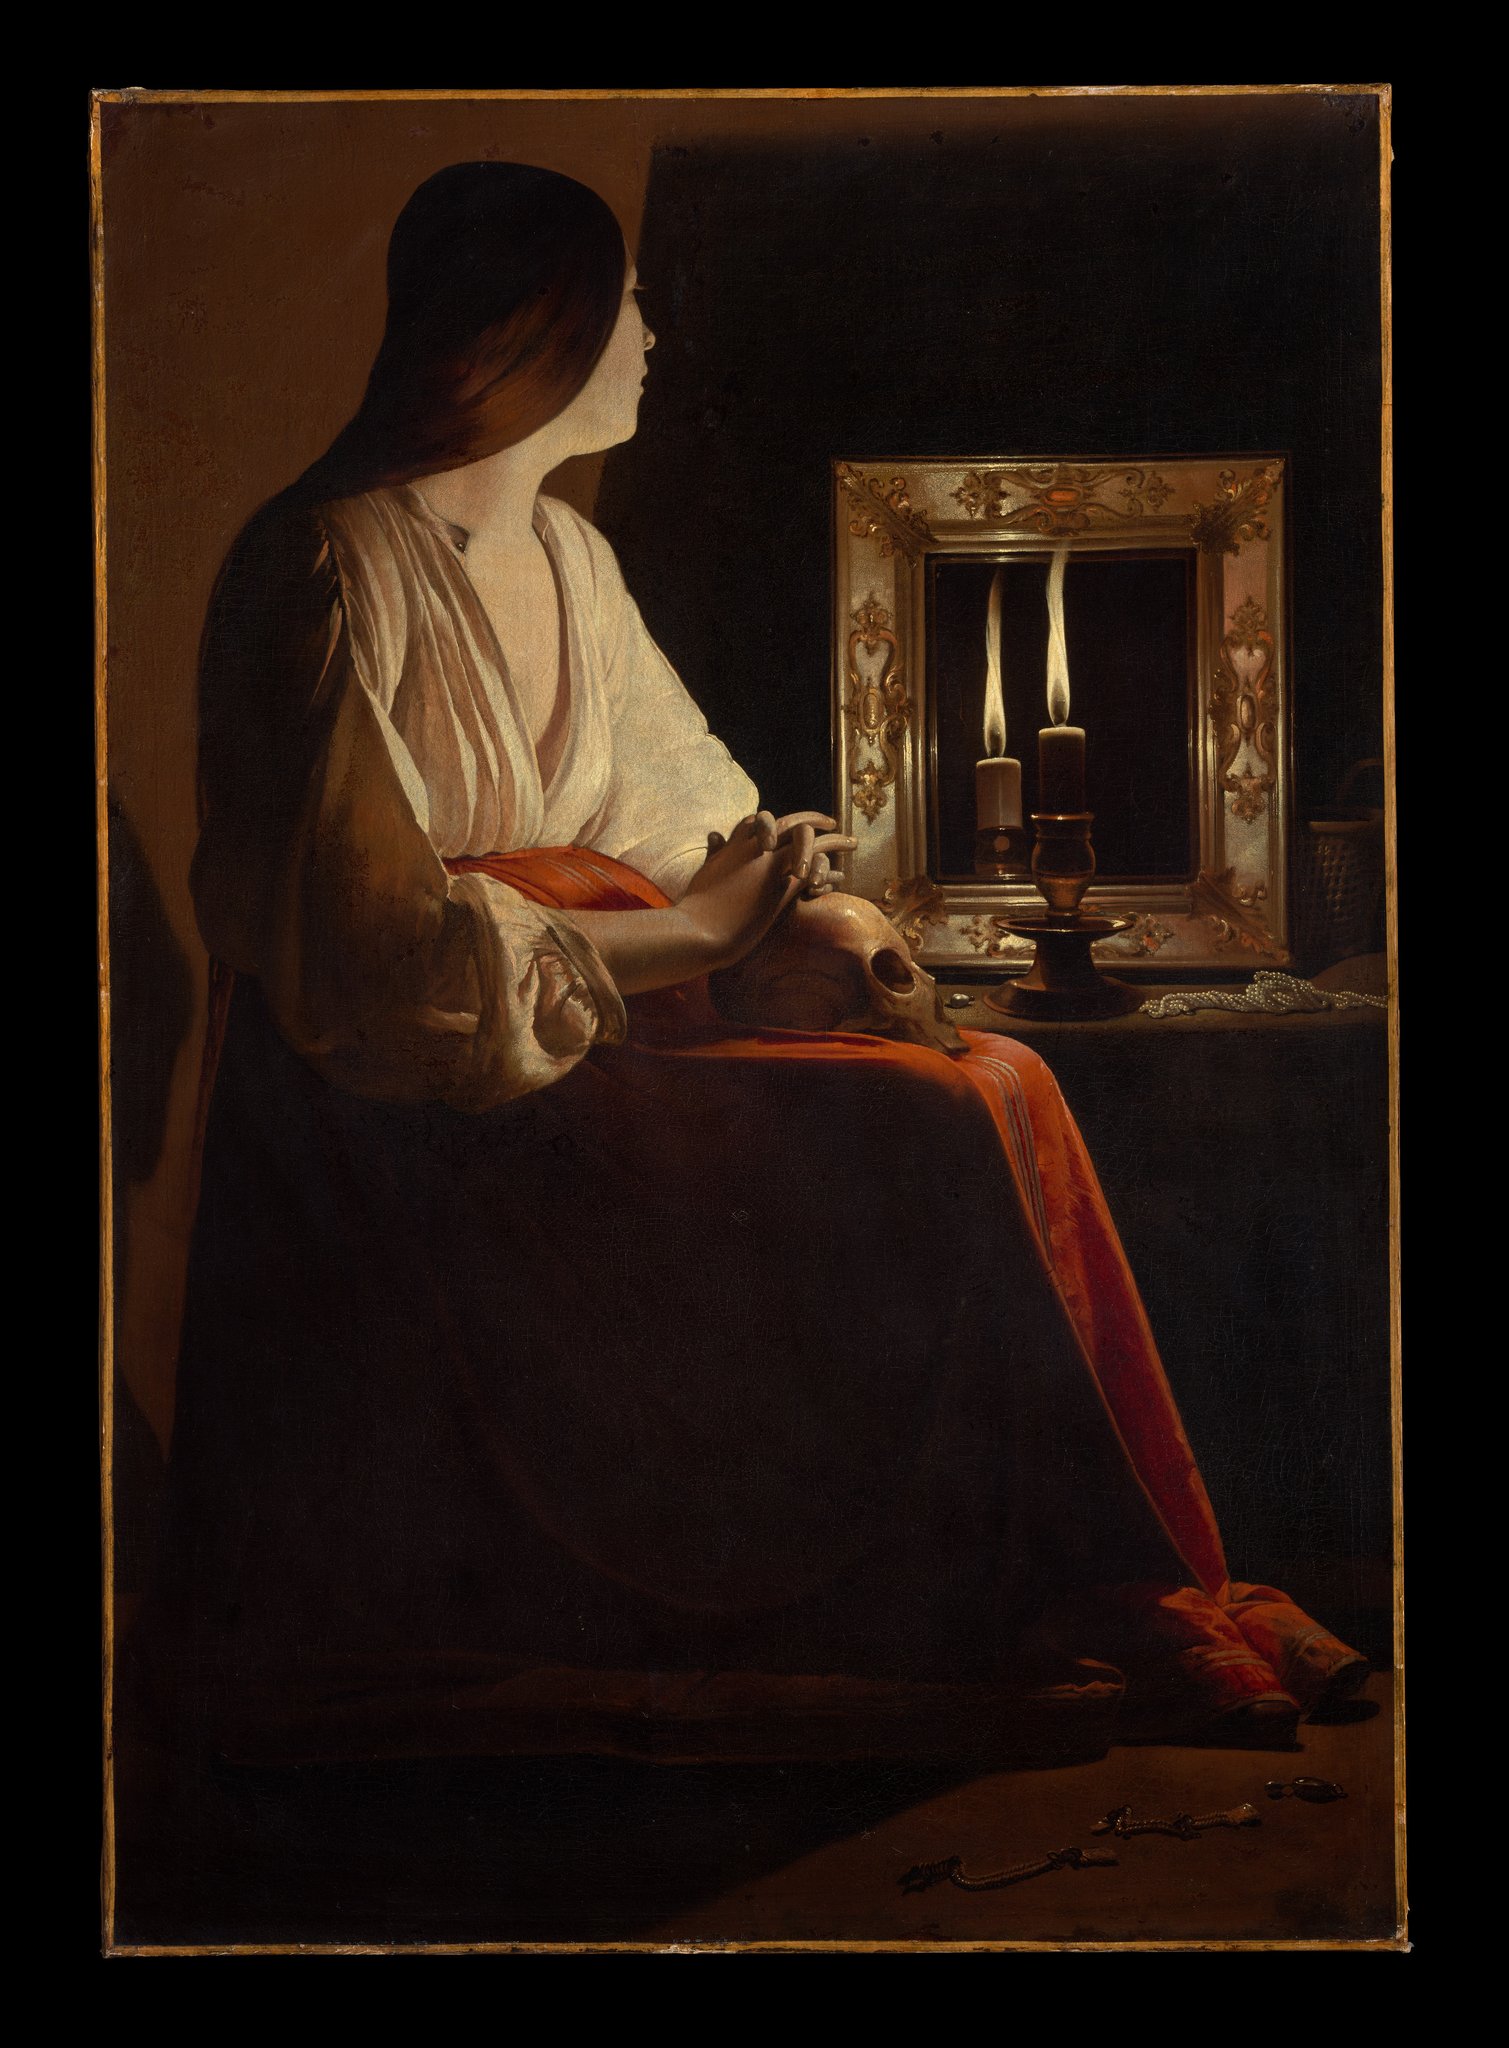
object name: painting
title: The Penitent Magdalen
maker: georges de la tour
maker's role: artist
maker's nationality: french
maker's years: 1593-1652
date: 1640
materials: canvas, oil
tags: skulls,mary magdalene,candles,mirrors